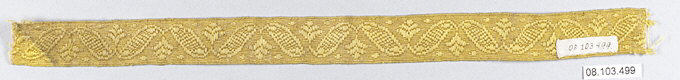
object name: galloon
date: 1701-1800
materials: cotton, silk